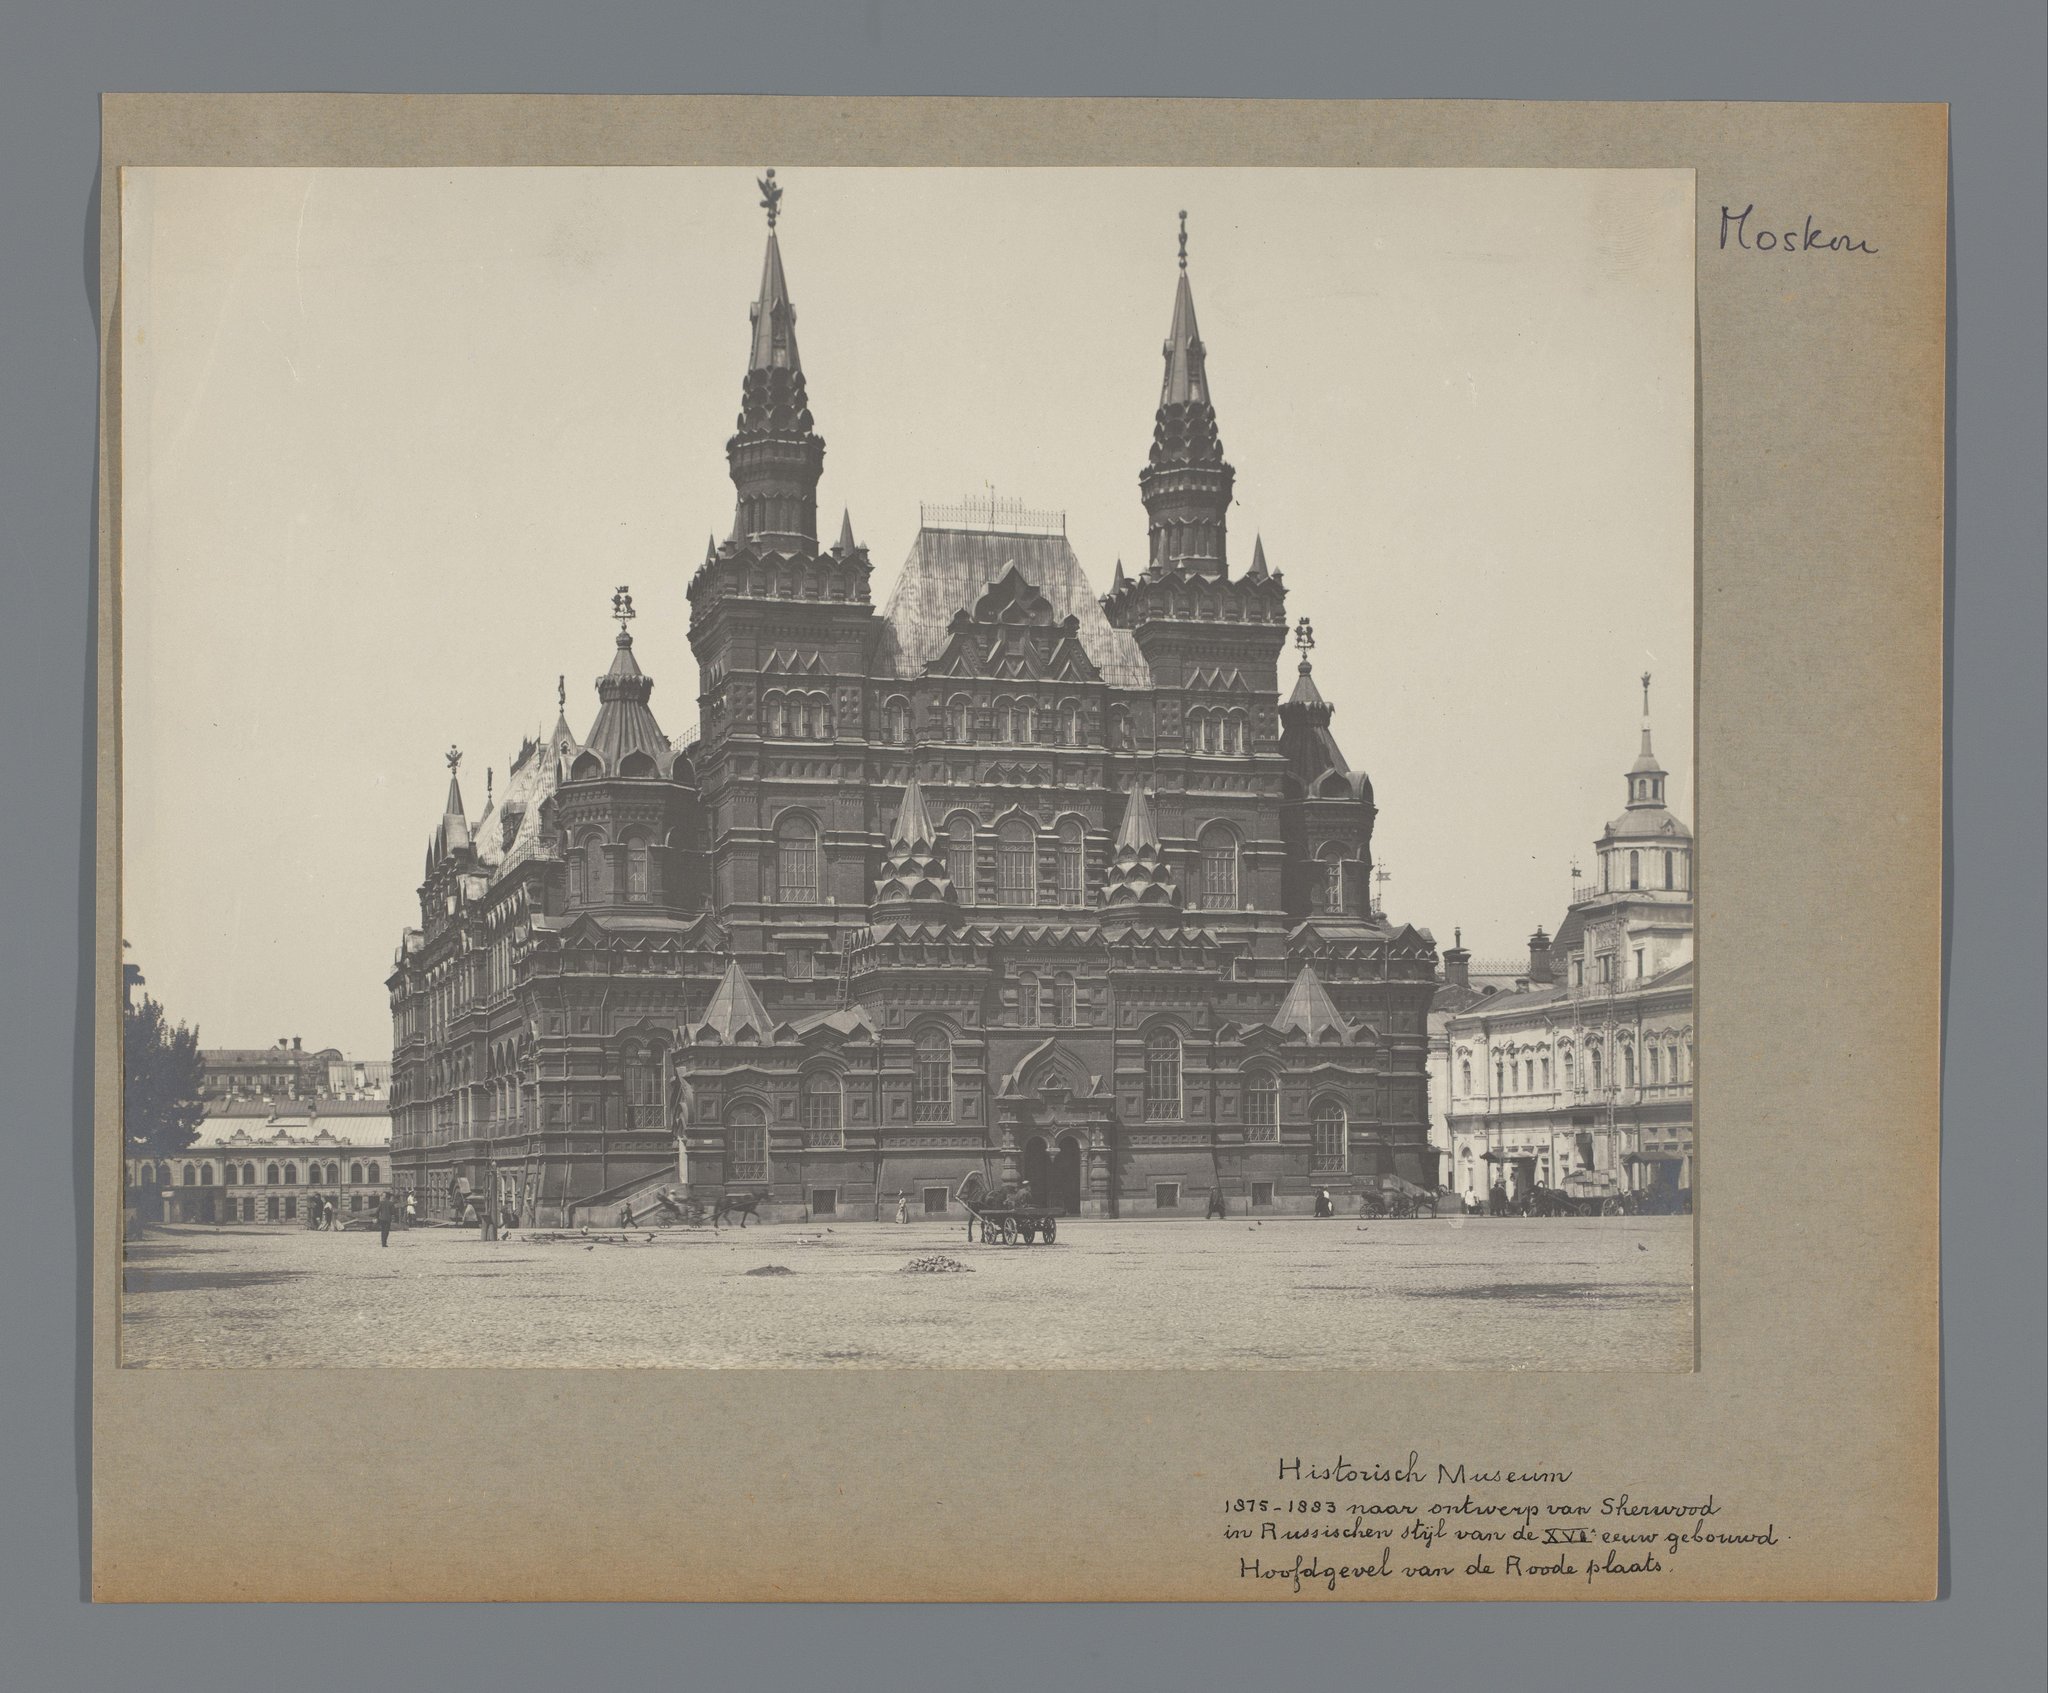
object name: photograph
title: Historisch Museum Moskou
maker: Anonymous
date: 1880-1930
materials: photographic support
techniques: gelatin silver print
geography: russia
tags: russia